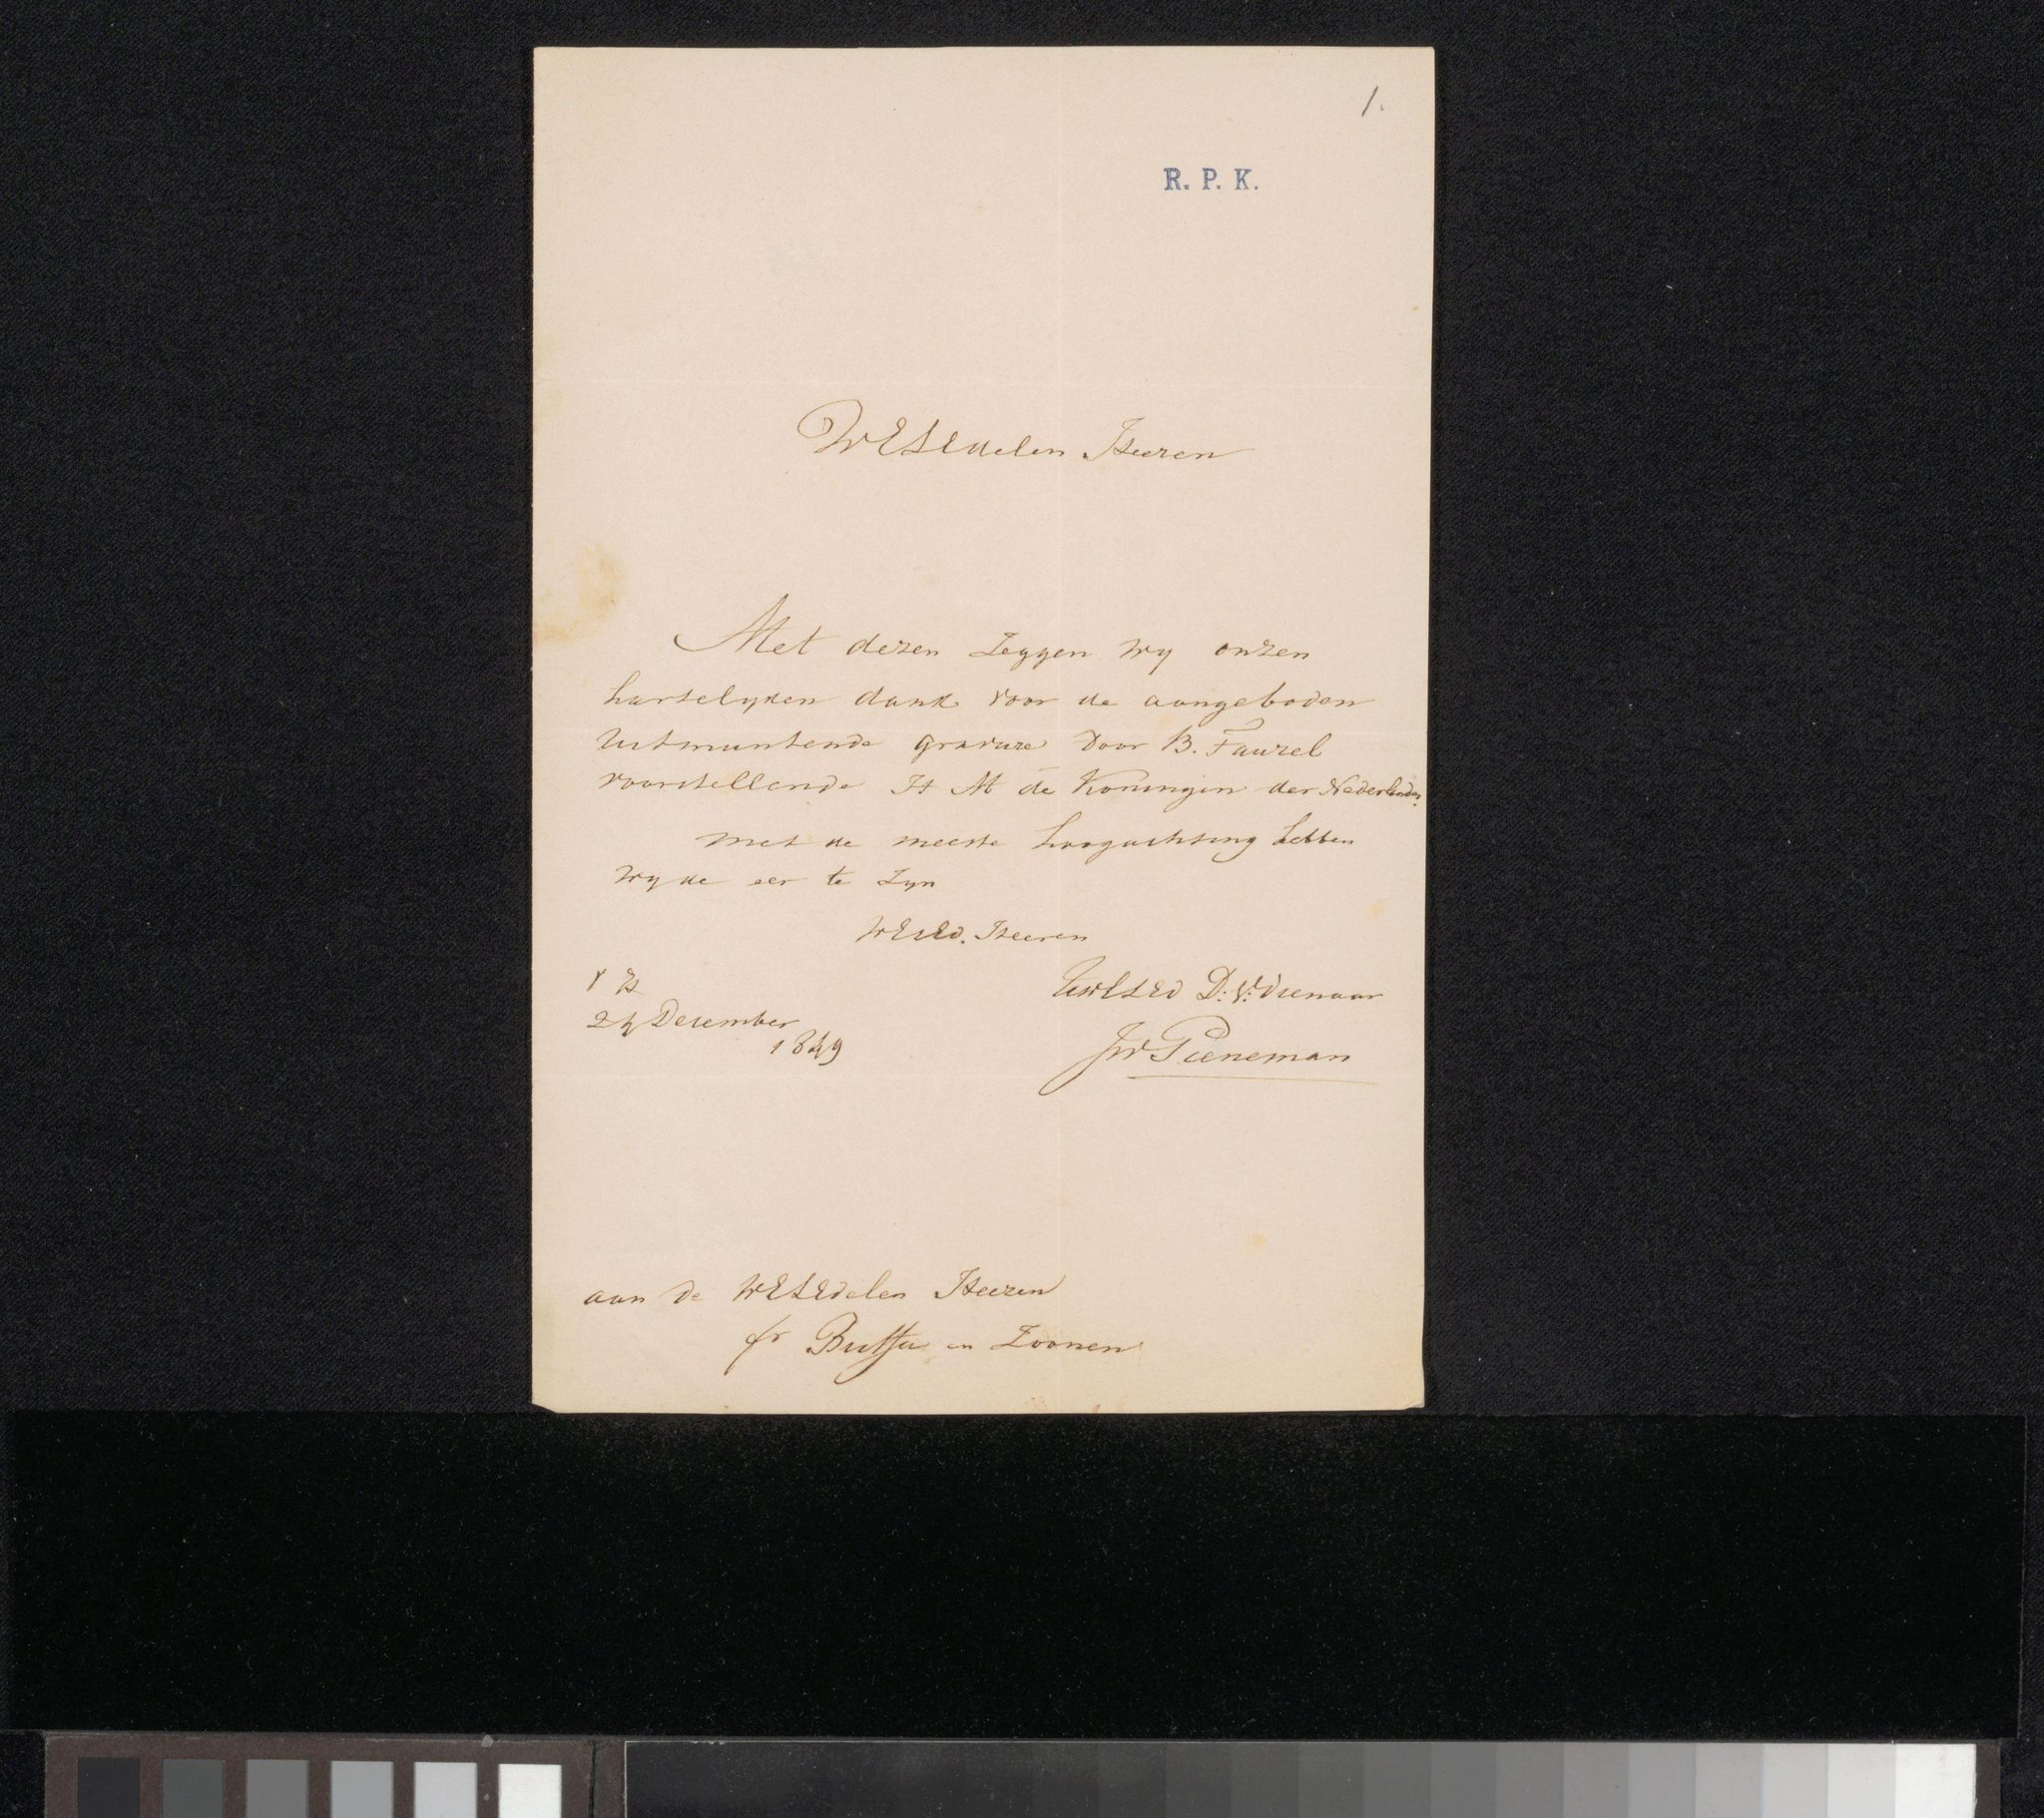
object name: letter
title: Brief aan Frans Buffa en Zonen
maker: jan willem pieneman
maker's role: draughtsman, painter, print maker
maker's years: 1779-1853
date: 1849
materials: ink, paper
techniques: pen, writing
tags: paris, amsterdam, print maker, draughtsman, benoit taurel, publisher, the graphic arts, historical persons (portraits and scenes from the life)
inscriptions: collector's mark: Lugt 2233